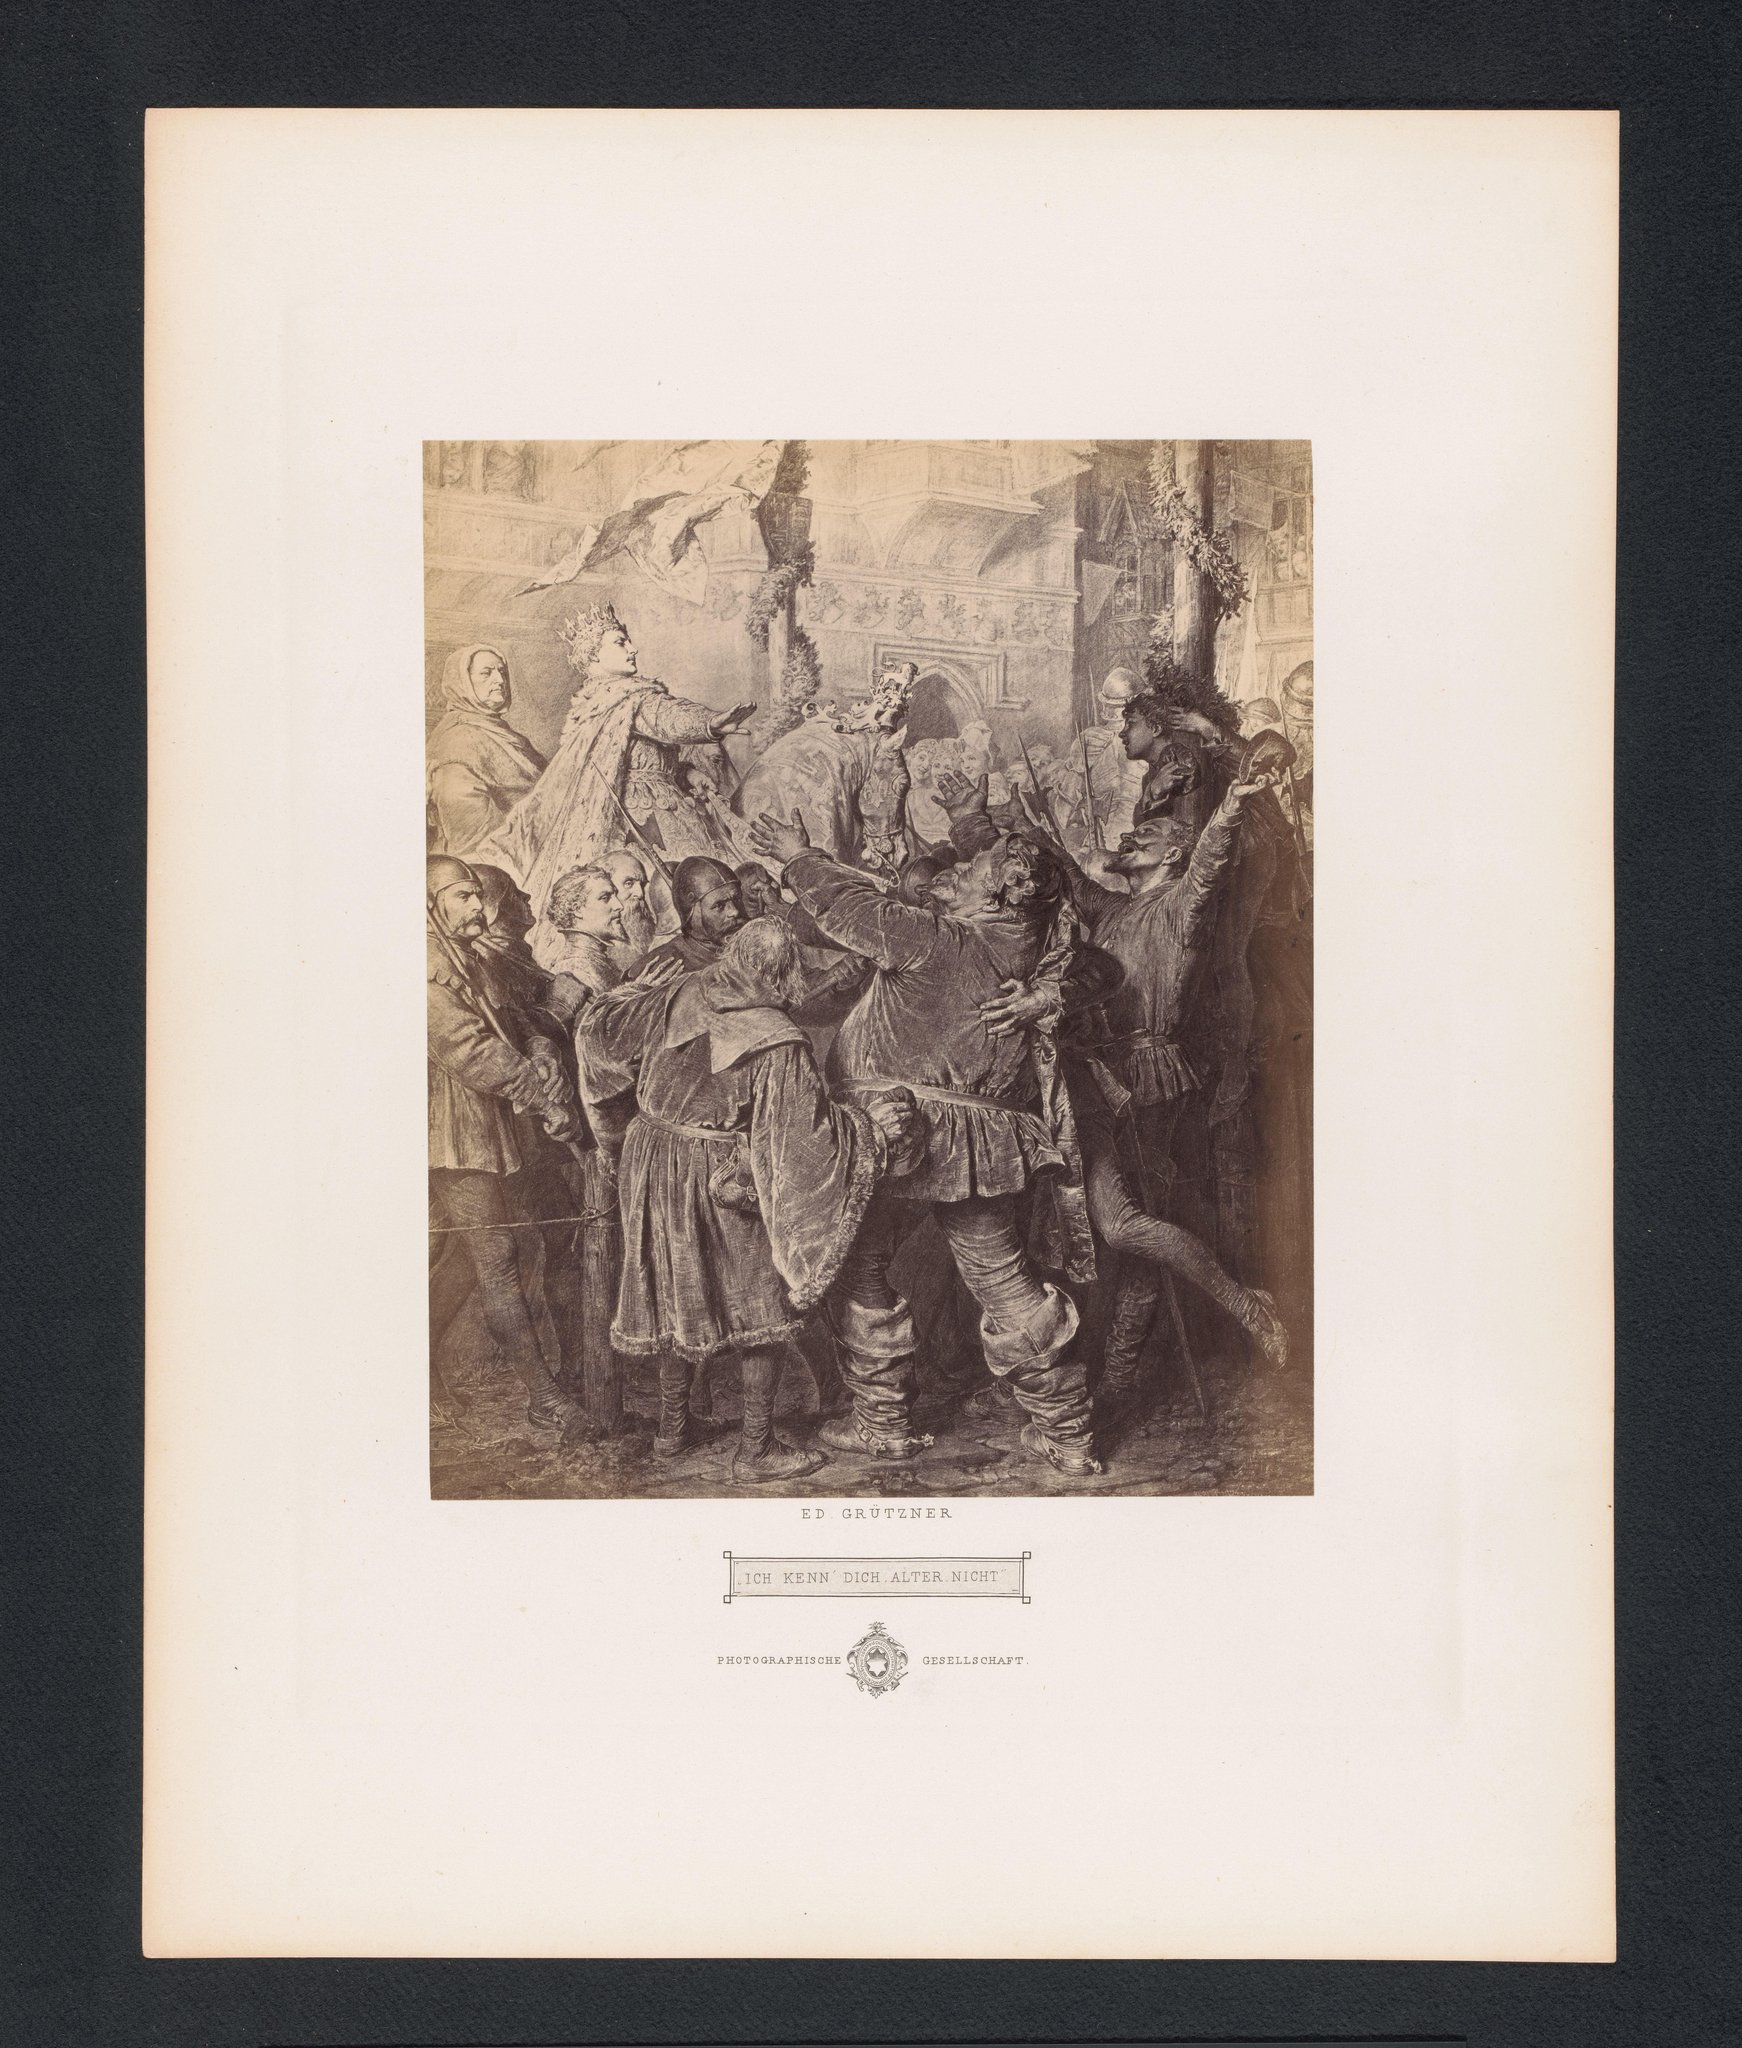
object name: reproduction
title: "Ich Kenn' Dich Alter Nicht"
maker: eduard von grützner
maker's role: painter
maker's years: 1846-1925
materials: photographic support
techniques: albumen print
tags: king, specific works of literature, falstaff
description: Deze foto maakt deel uit van een omslag met zeven foto's, een titelblad met foto en een tekstblad.